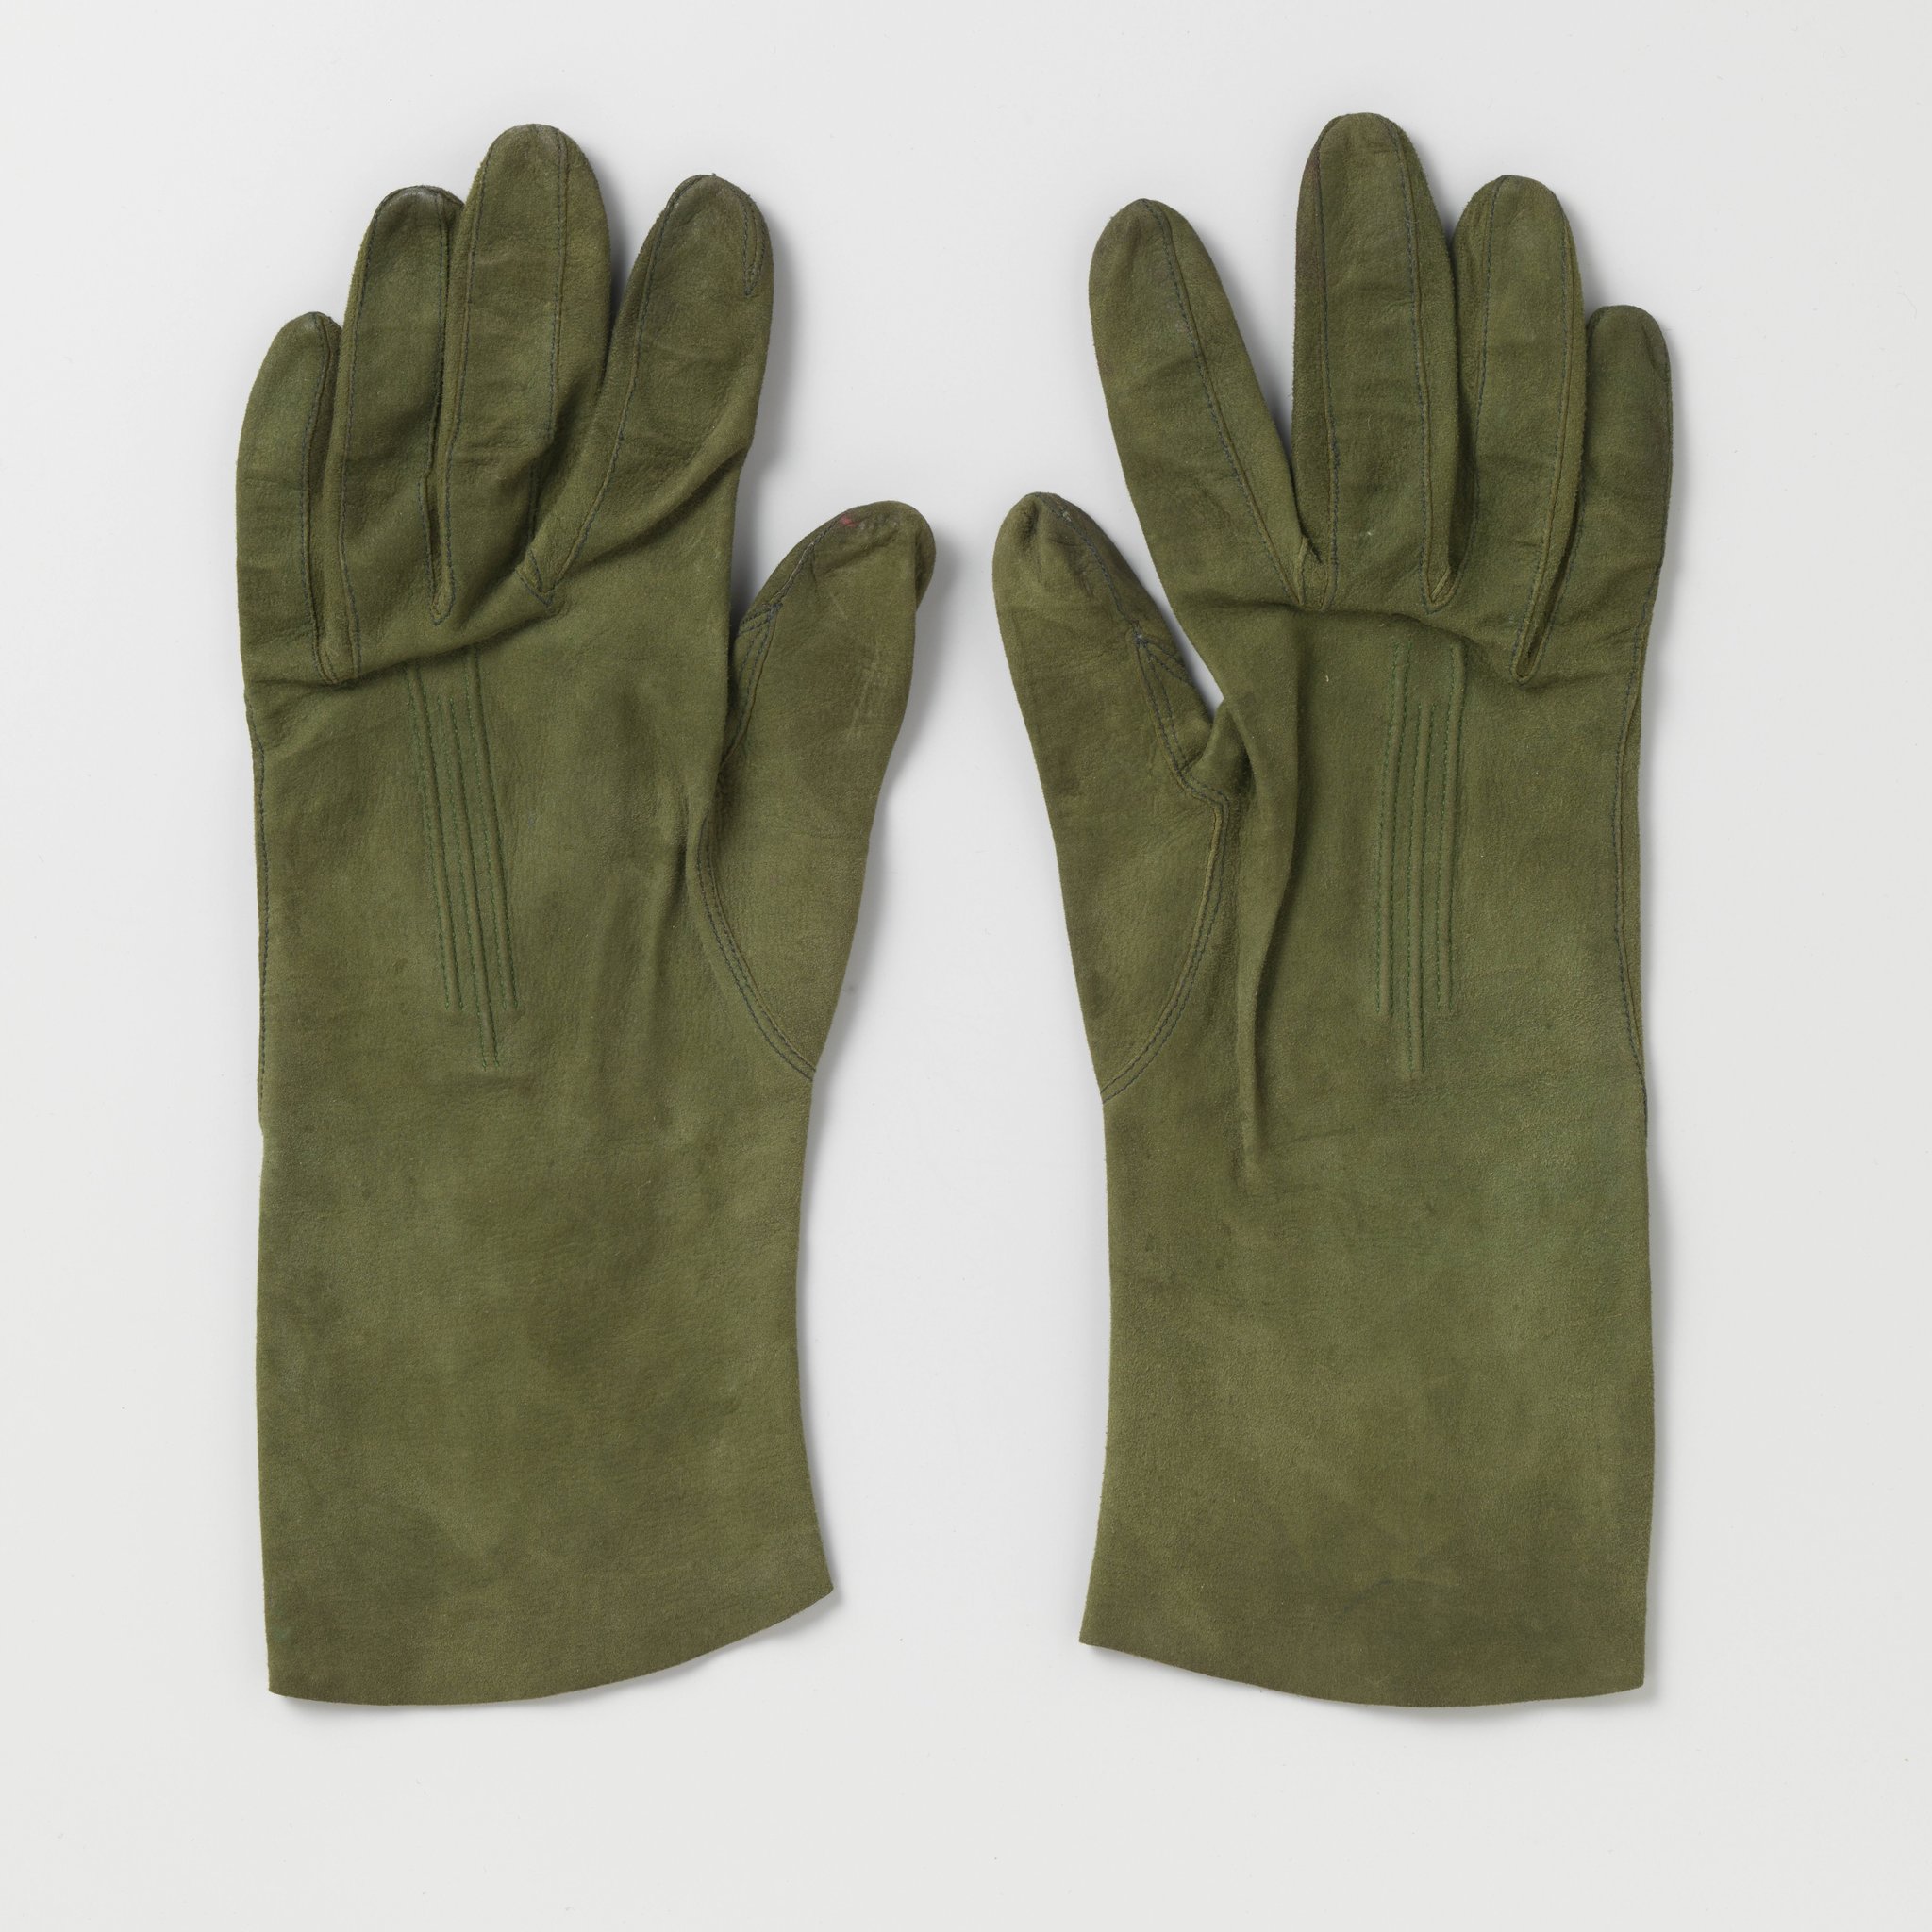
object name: clothing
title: Pair of suede gloves with receding cords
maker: Anonymous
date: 1900-1915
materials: leather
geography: netherlands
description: Rechterhandschoen van groene suède, op de rug drie verspringende koorden.